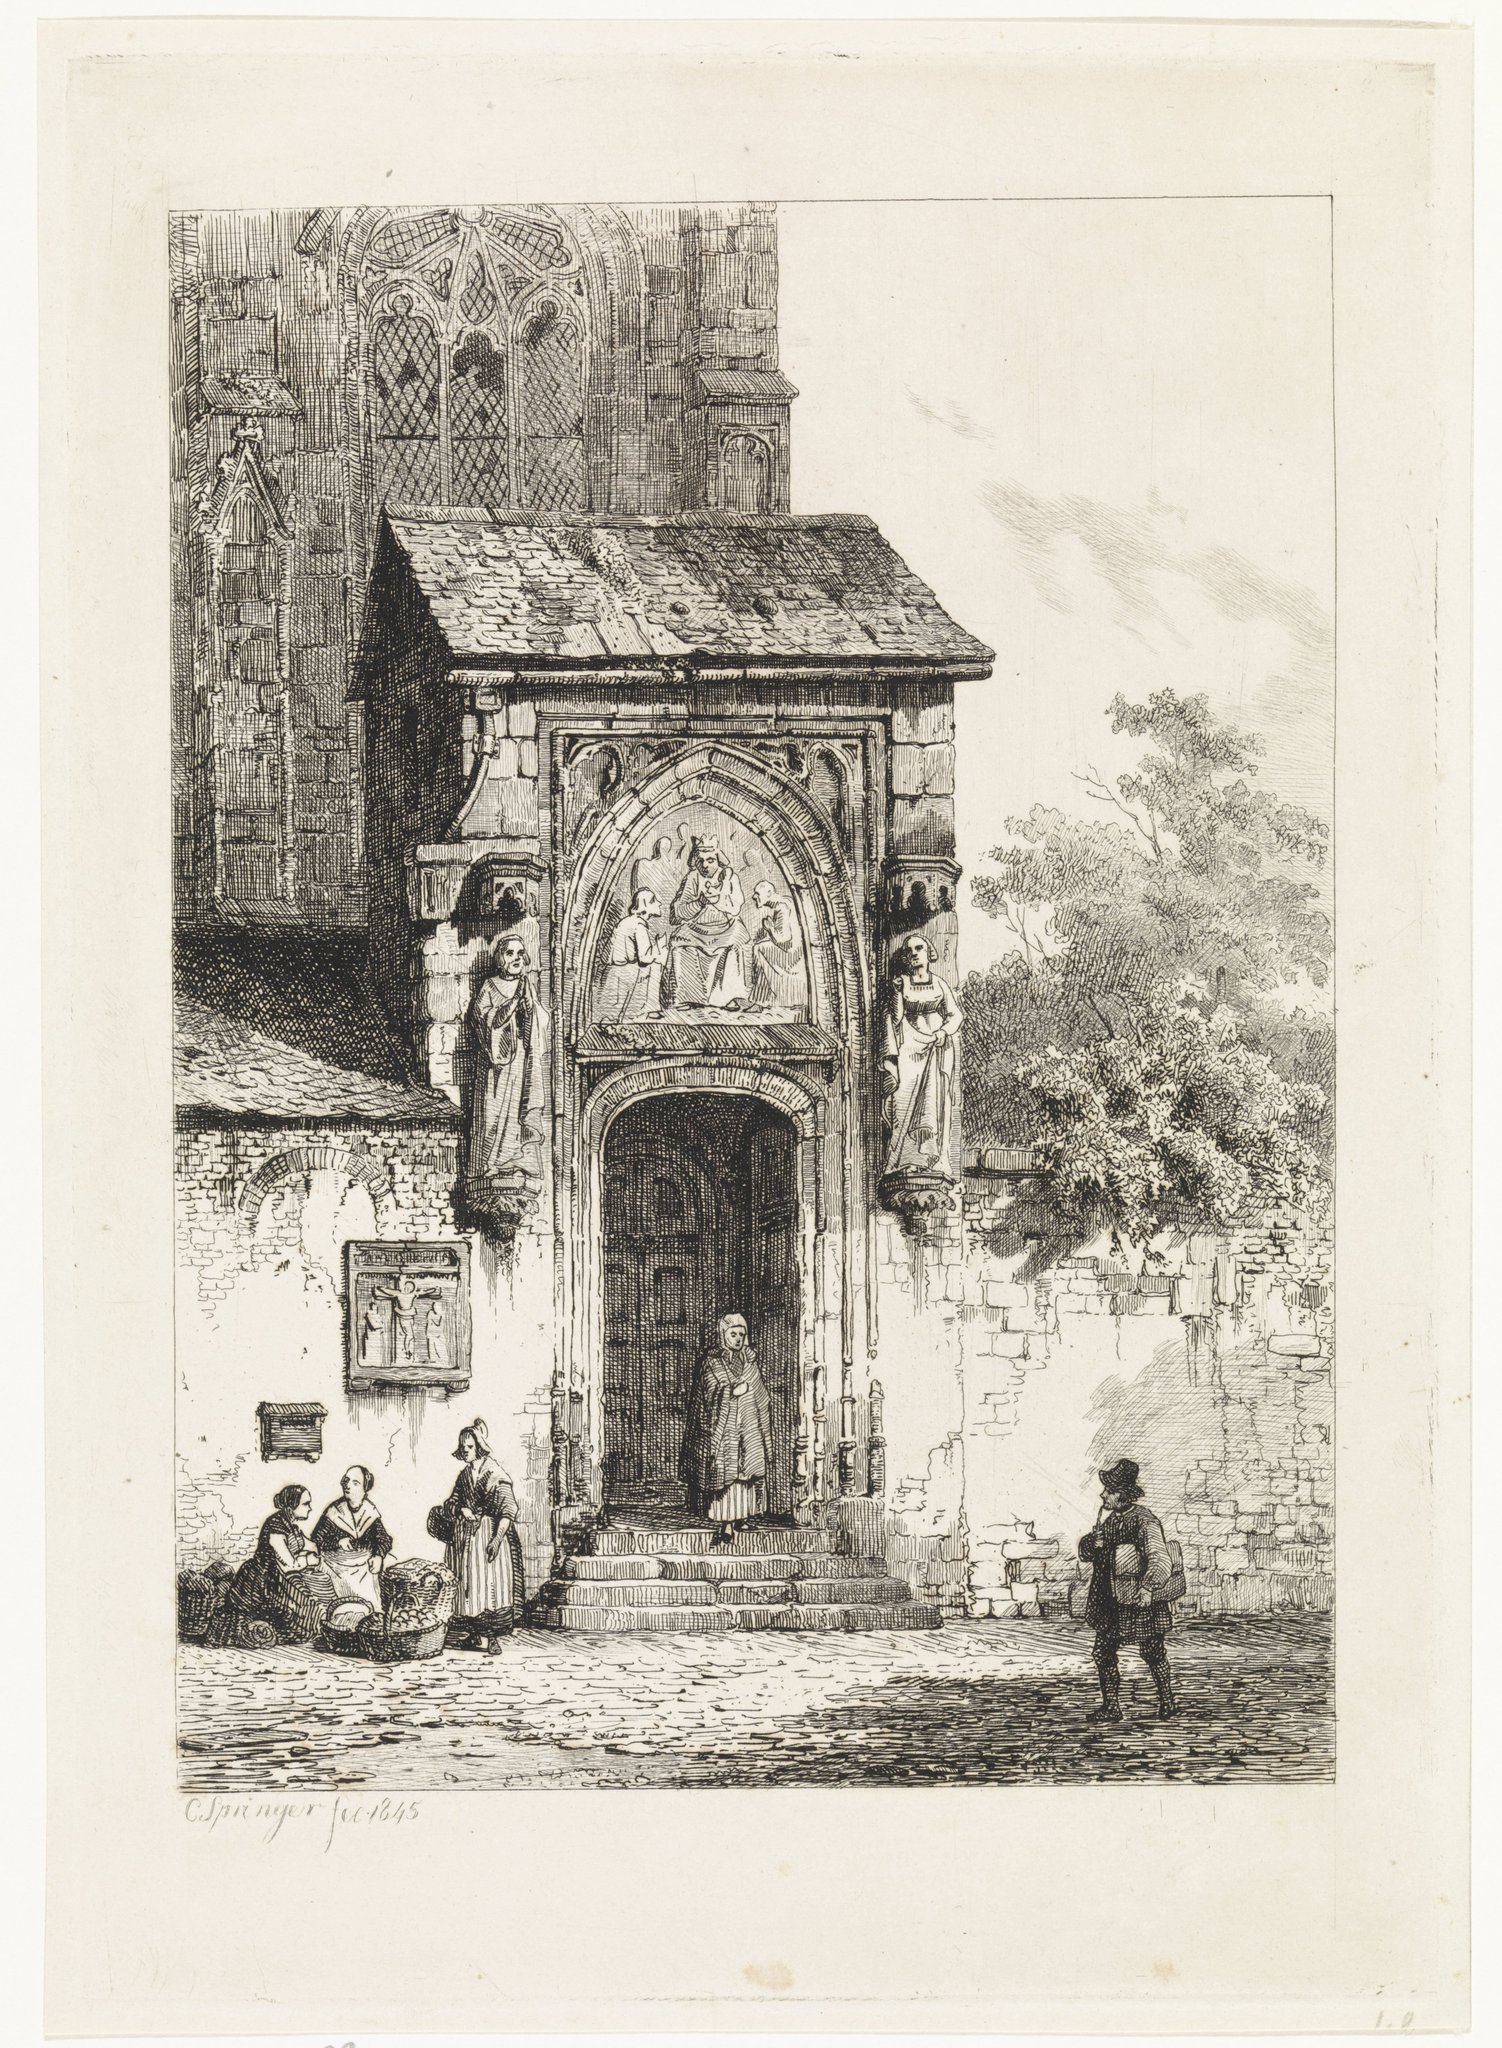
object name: print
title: Gezicht op een kerkportaal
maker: cornelis springer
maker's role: draughtsman, painter, print maker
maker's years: 1817-1891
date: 1845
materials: paper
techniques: drypoint, engraving, etching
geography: amsterdam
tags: parts of church exterior and annexes: portal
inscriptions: collector's mark: Lugt 2228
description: Een vrouw stapt uit het portaal van een kerk. Links zitten drie vrouwen bijeen, rechts loopt een man.